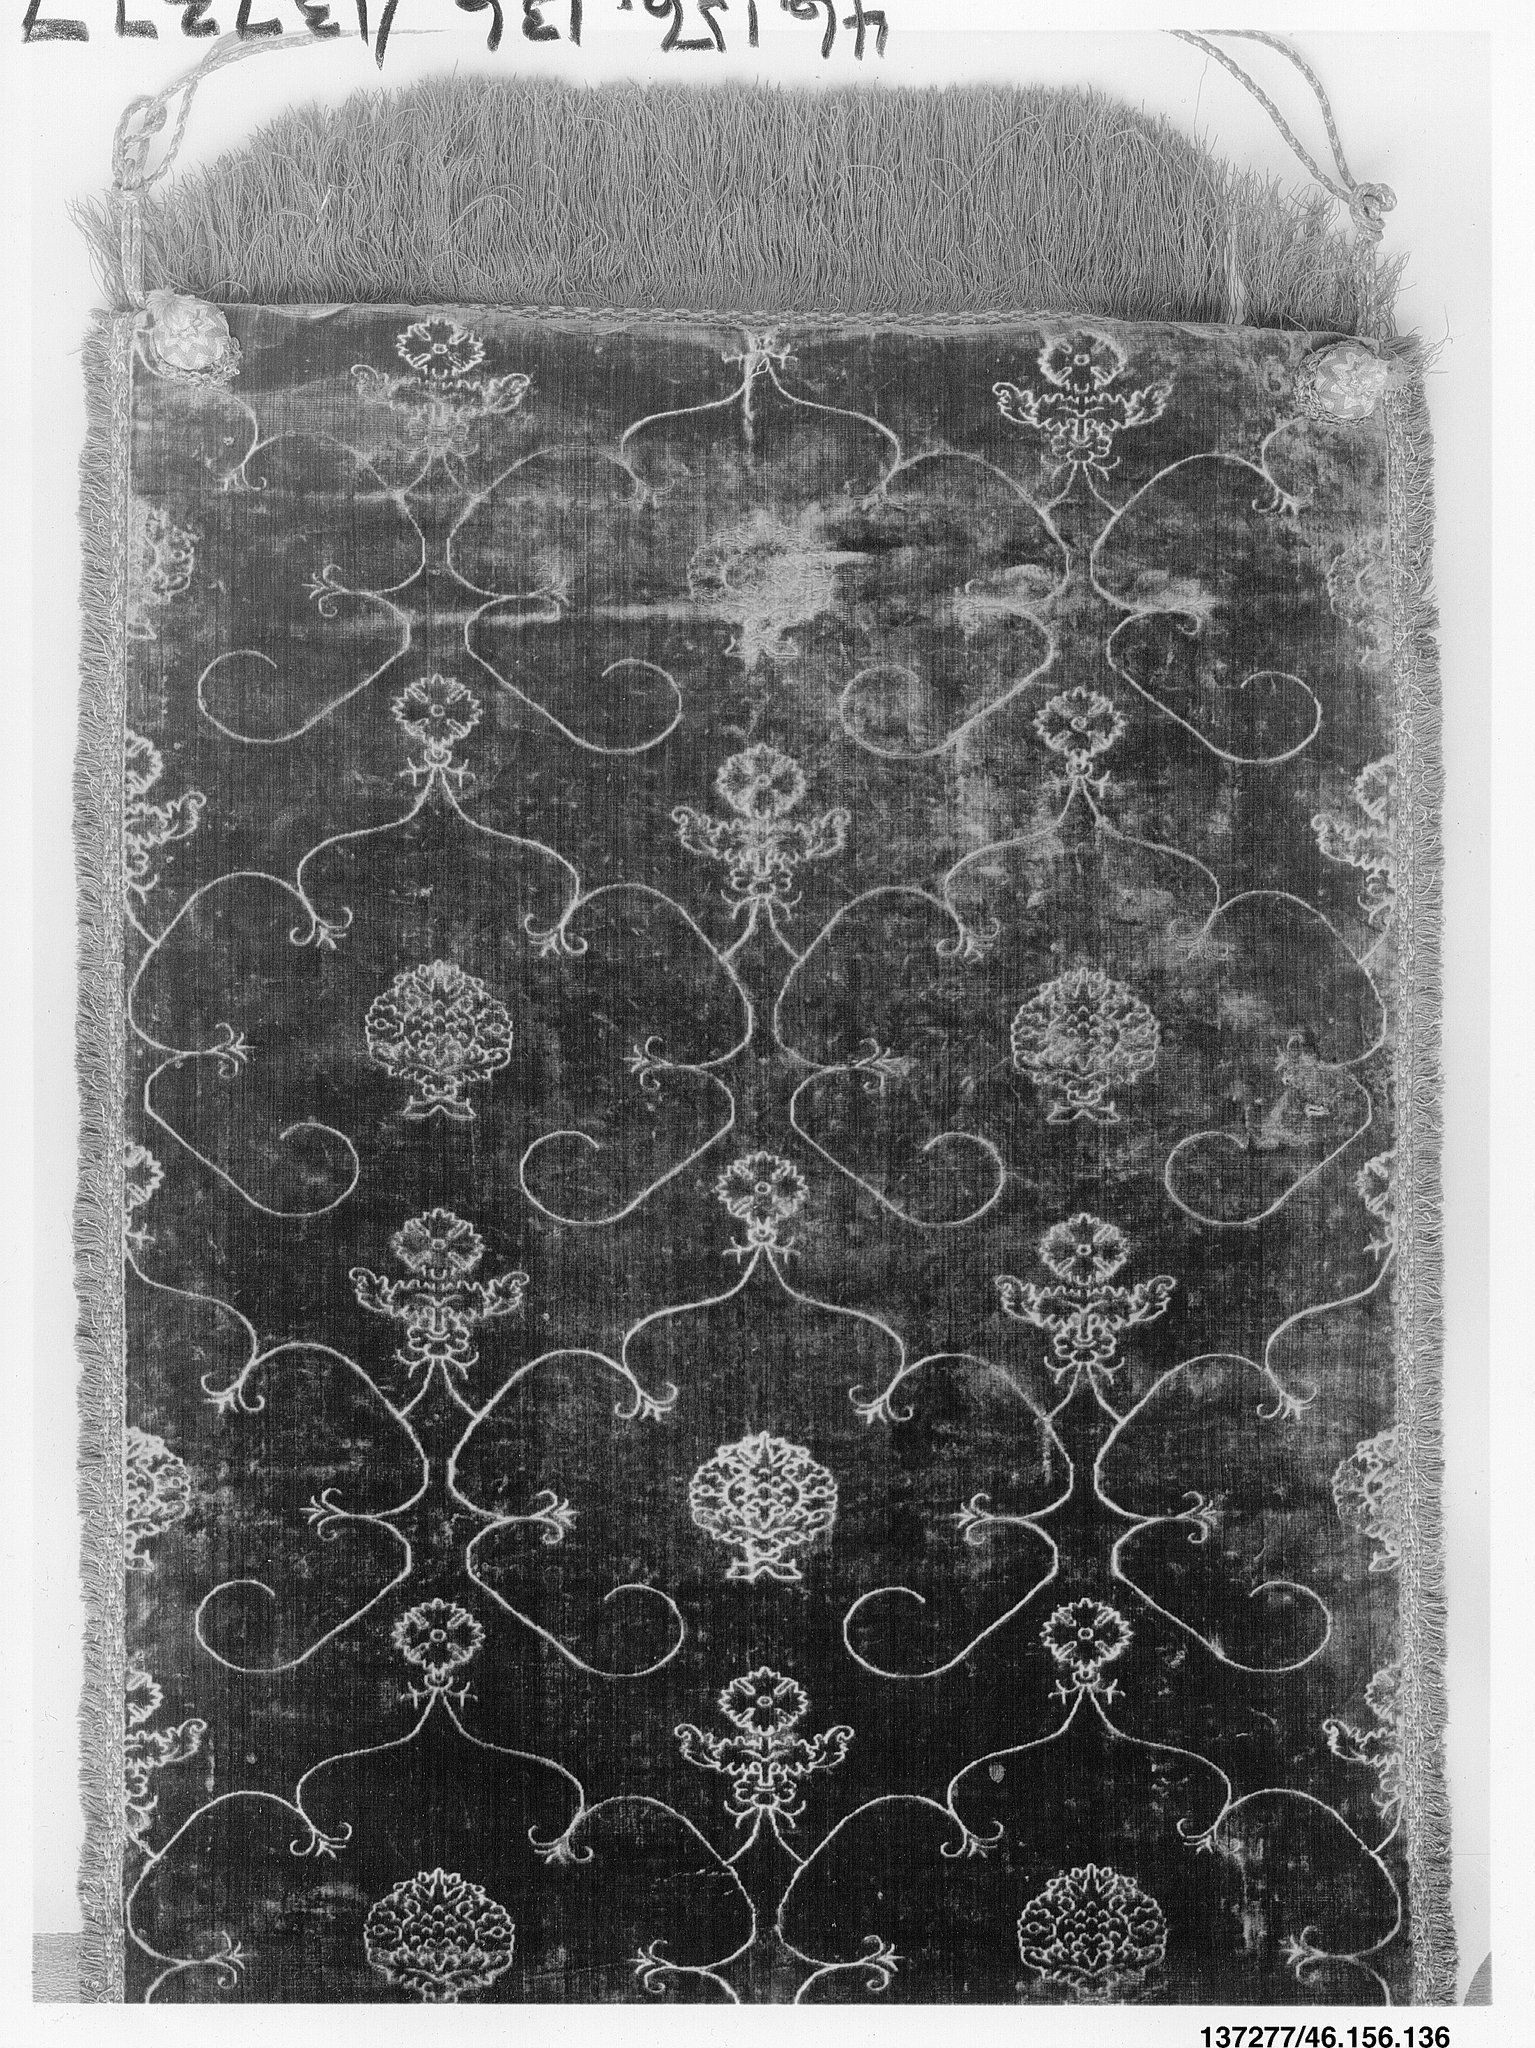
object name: piece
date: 1467-1500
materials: silk